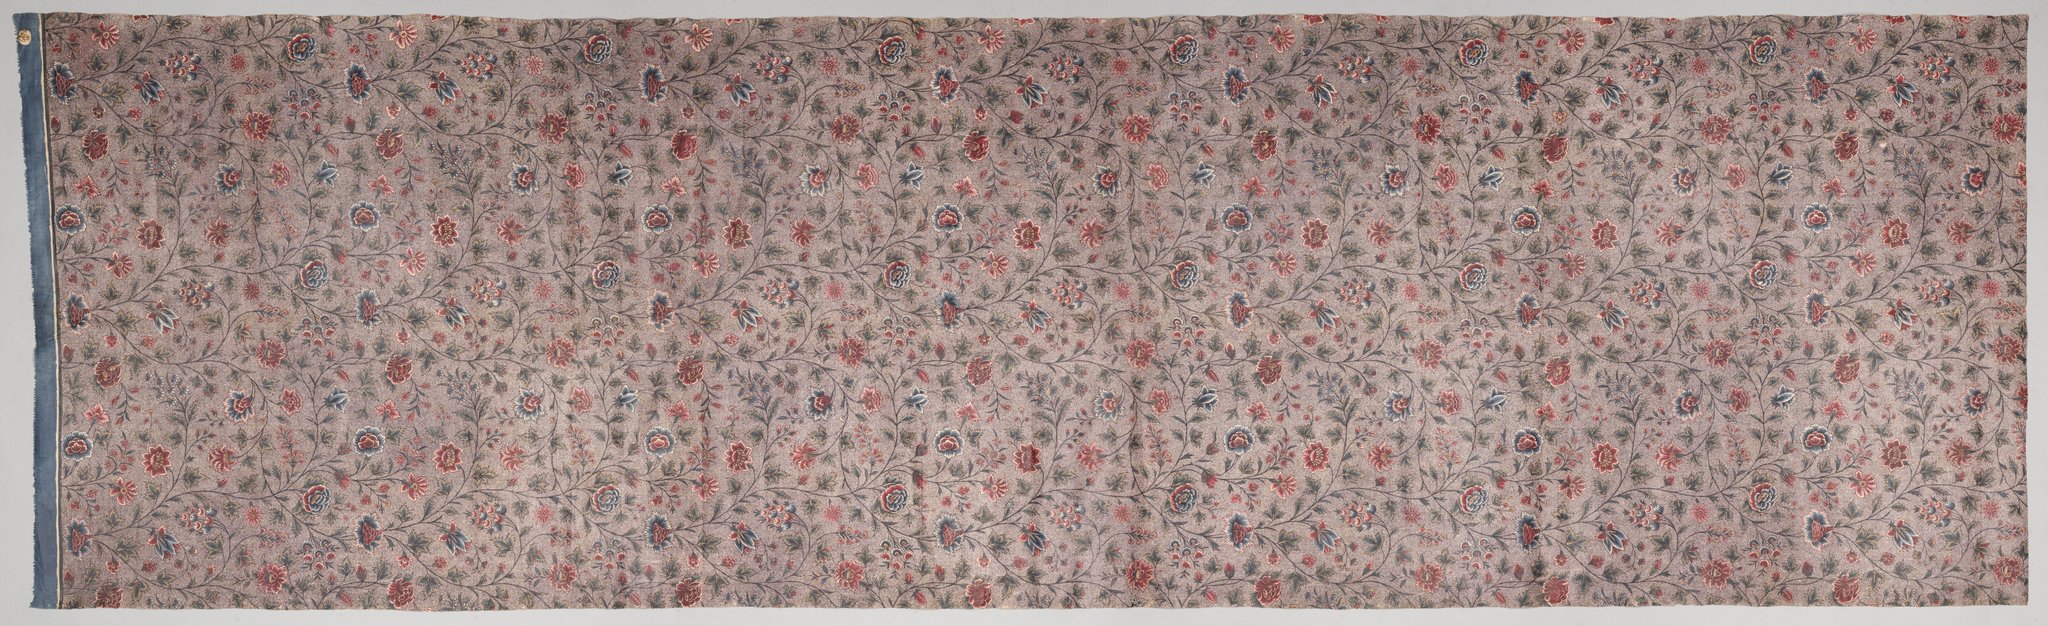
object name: textile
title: Fragment sits met patroon van bloemen en bladeren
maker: Anonymous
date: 1775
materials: cotton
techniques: painting, painted, resist dyed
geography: coromandel coast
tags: verenigde oostindische compagnie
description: Fragment sits, katoen, geverfd door middel van beits- en uitsparingstechniek, geschilderd. Dessin: twee rijen bloem- en bladarrangementen - in totaal vijf stuks - waartussen kleinere bloemen en bladeren, geschilderd in verschillende tinten rood, aubergine, blauw, groen en geel tegen wit fond; omtrekken in zwart en rood. Opmerking: het fragment is gepapt en is waarschijnlijk nooit gebruikt. Opgespeld papiertje met opschrift in inkt in 18de eeuws handschrift: DIT ZITS KOST 6 GLS DE EL VAN /WW DE VRIES 1775. Oosters textiel. Op de achterzijde een VOC-stempel.